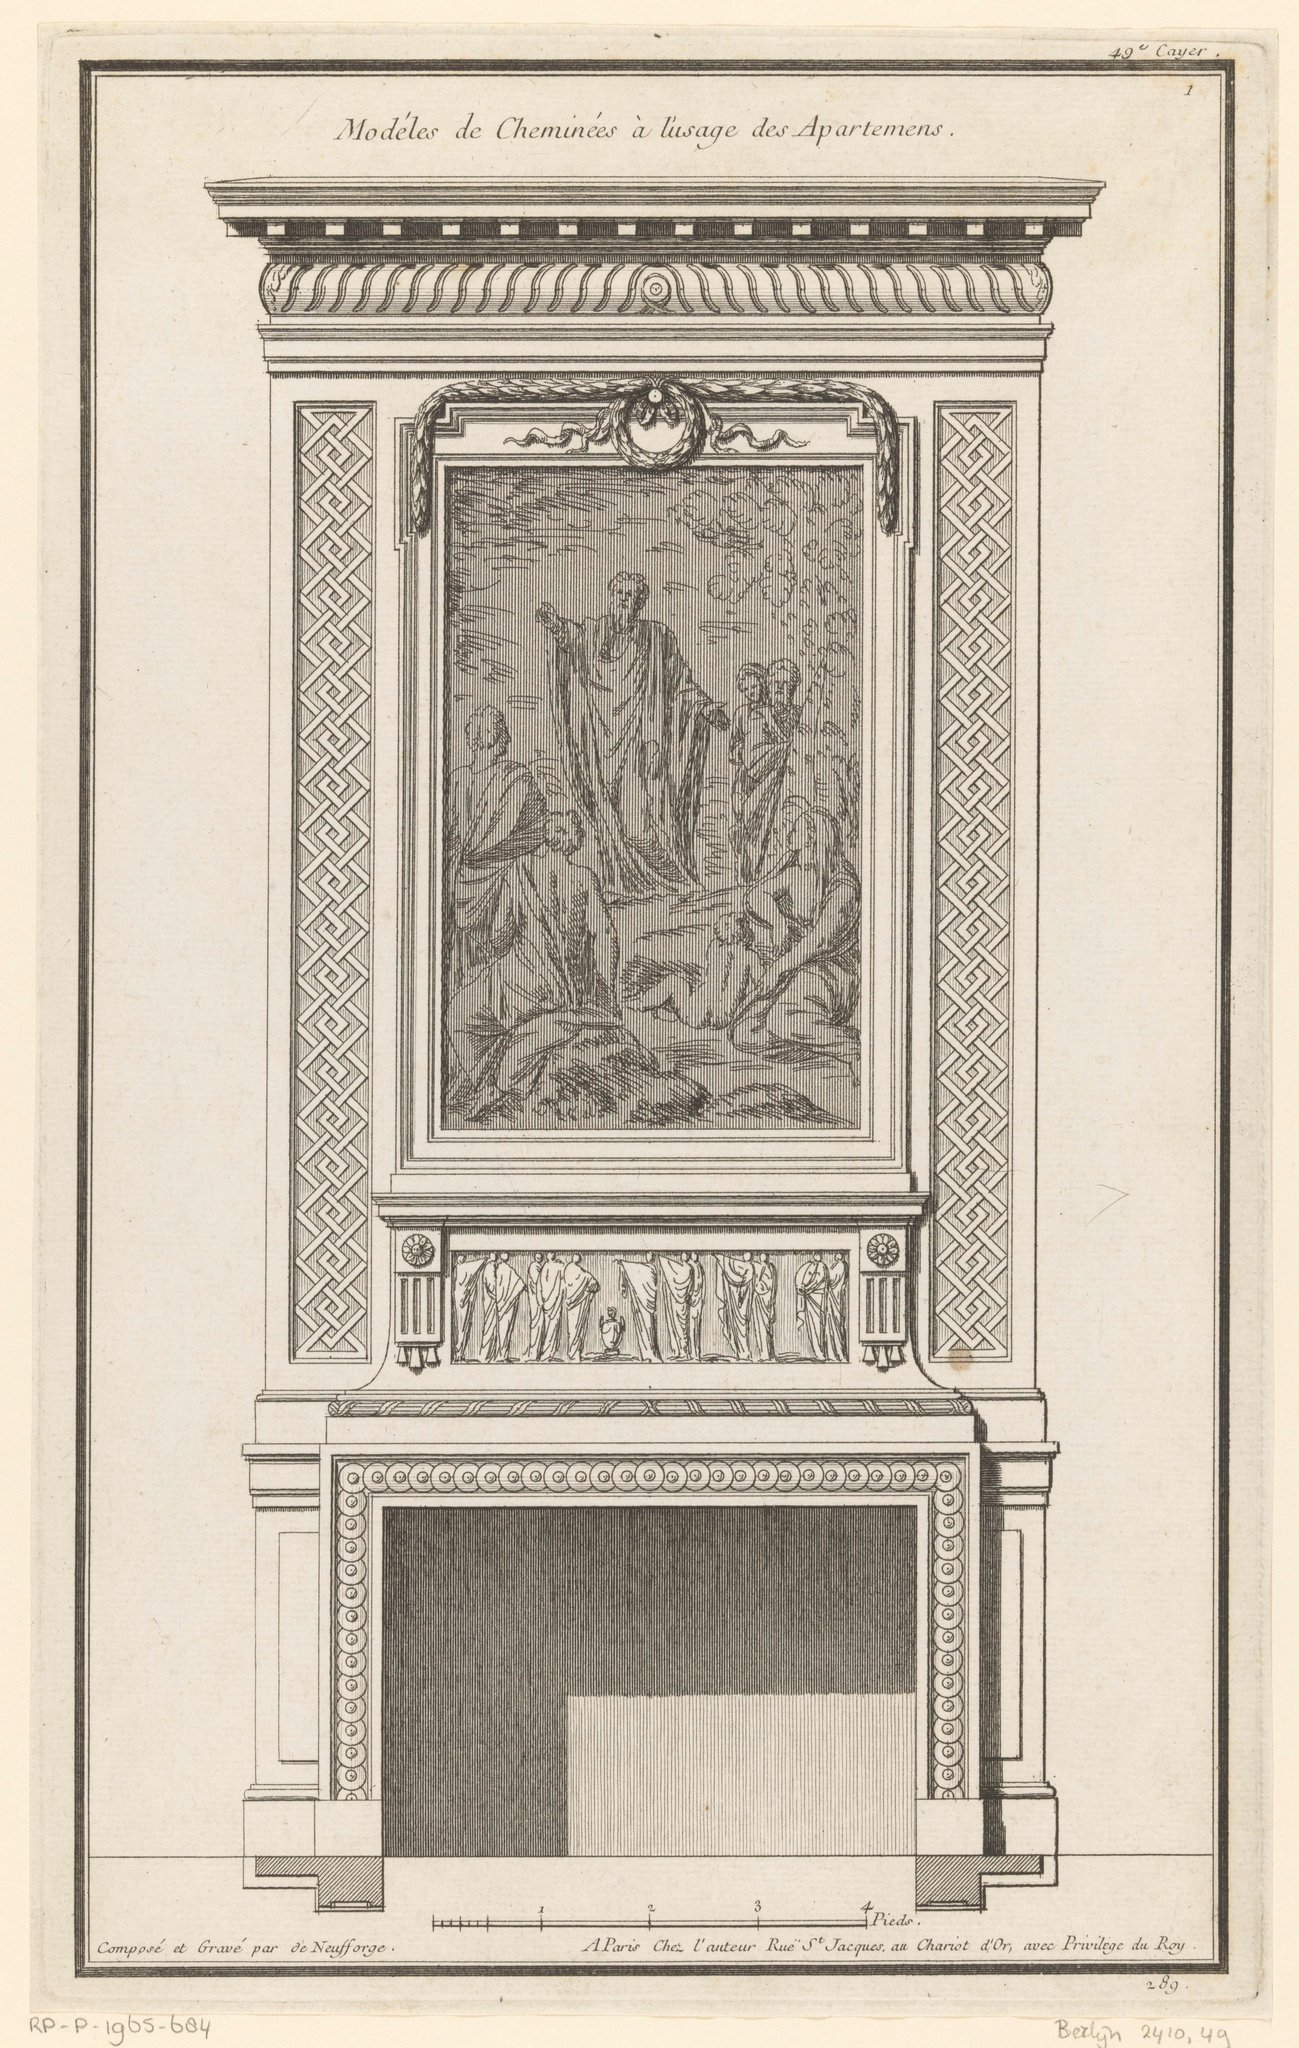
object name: print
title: Schouw met beschilderd paneel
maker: jean françois de neufforge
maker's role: print maker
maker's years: 1714-1791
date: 1763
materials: paper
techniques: etching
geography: paris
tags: panelling, open hearth, fire-place, picture, painting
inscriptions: collector's mark: Lugt 2228, collector's mark: Lugt 2760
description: Een geornamenteerde schouw met een klein paneel met figuren en een groot beschilderd paneel met figuren luisterend naar een predikende man in een landschap. Prentnummer 289.